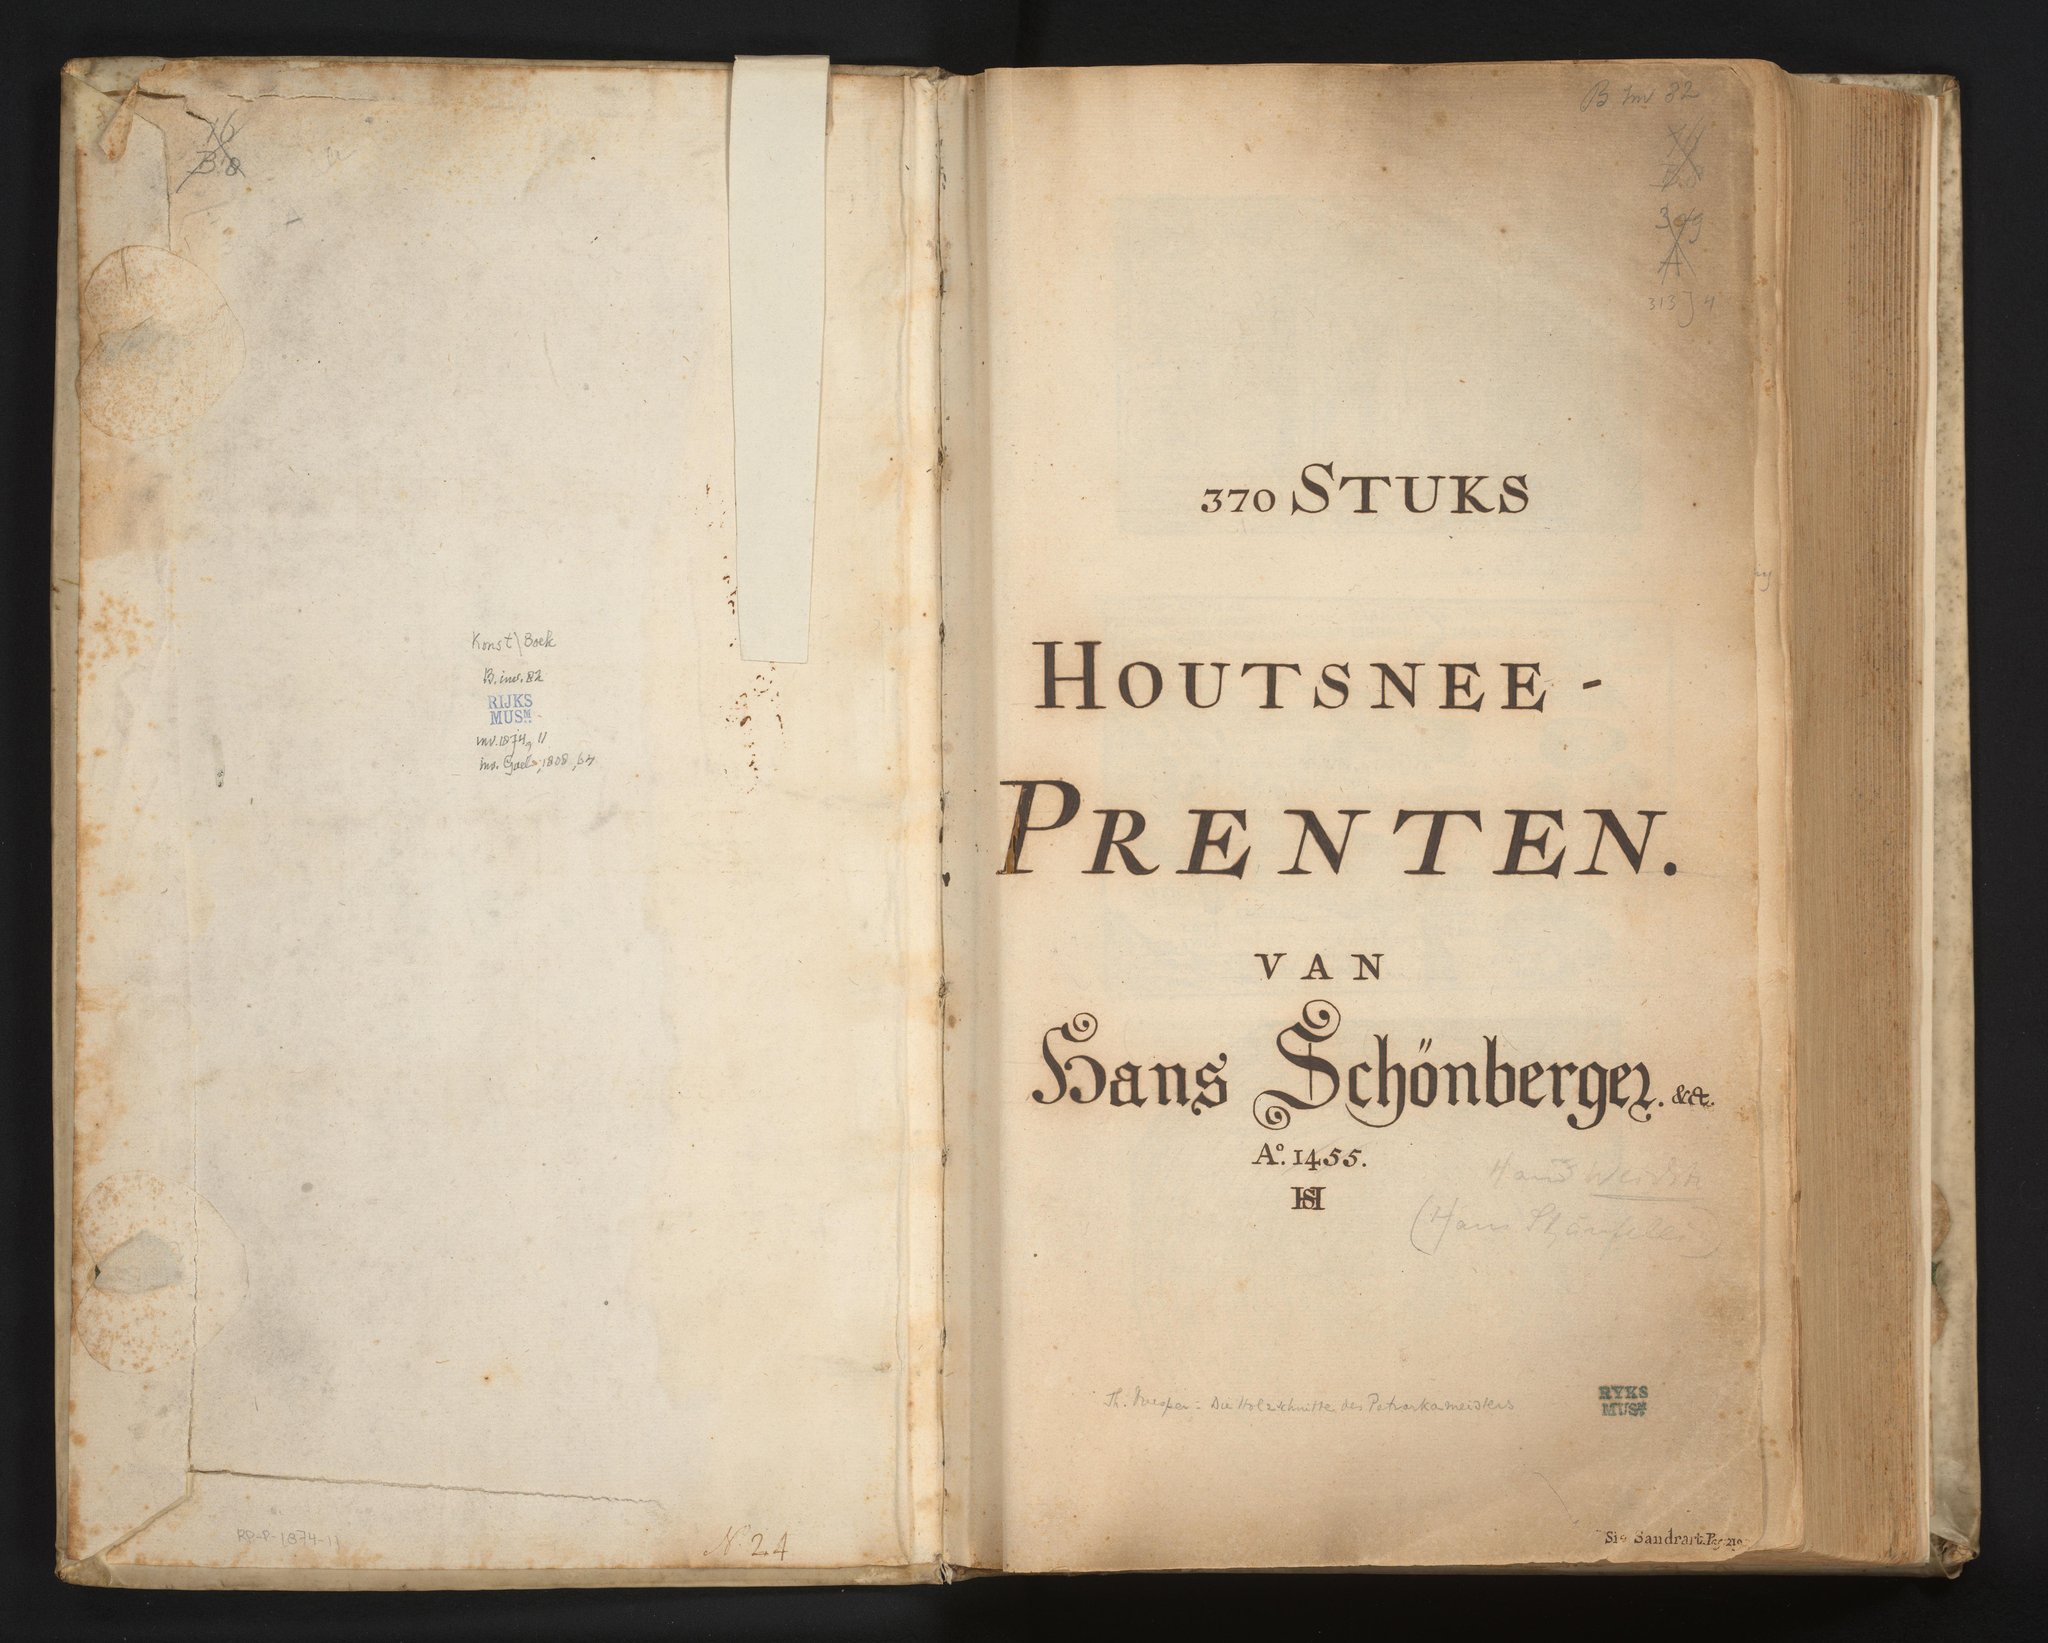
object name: album leaf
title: Titelprent voor een prentalbum met moraliserende voorstellingen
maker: Anonymous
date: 1455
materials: paper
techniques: etching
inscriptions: collector's mark: Lugt 2166, annotation: ‘Hans Weiditz (Hans Schäufelein)’, collector's mark: Lugt 2165, annotation: ‘Th. Musper: Die Holzschnitte des Petrarkameisters’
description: De tekst rechtsonder op de titelprent verwijst naar volume één, boek drie, hoofdstuk twee en pagina 219 van Joachim von Sandrarts boek uit 1675 'Der Teutschen Academie (...) / Von Der Hoch- und Nieder-Teutschen berühmten Mahler/ Bildhauer und Baumeister/ Leben und Lob.'. Door deze referentie en de datering van de boekillustraties (publicatiedata) kan worden aangenomen dat dit factice album ouder is dan de gedrukte datum op de titelprent '1455'.